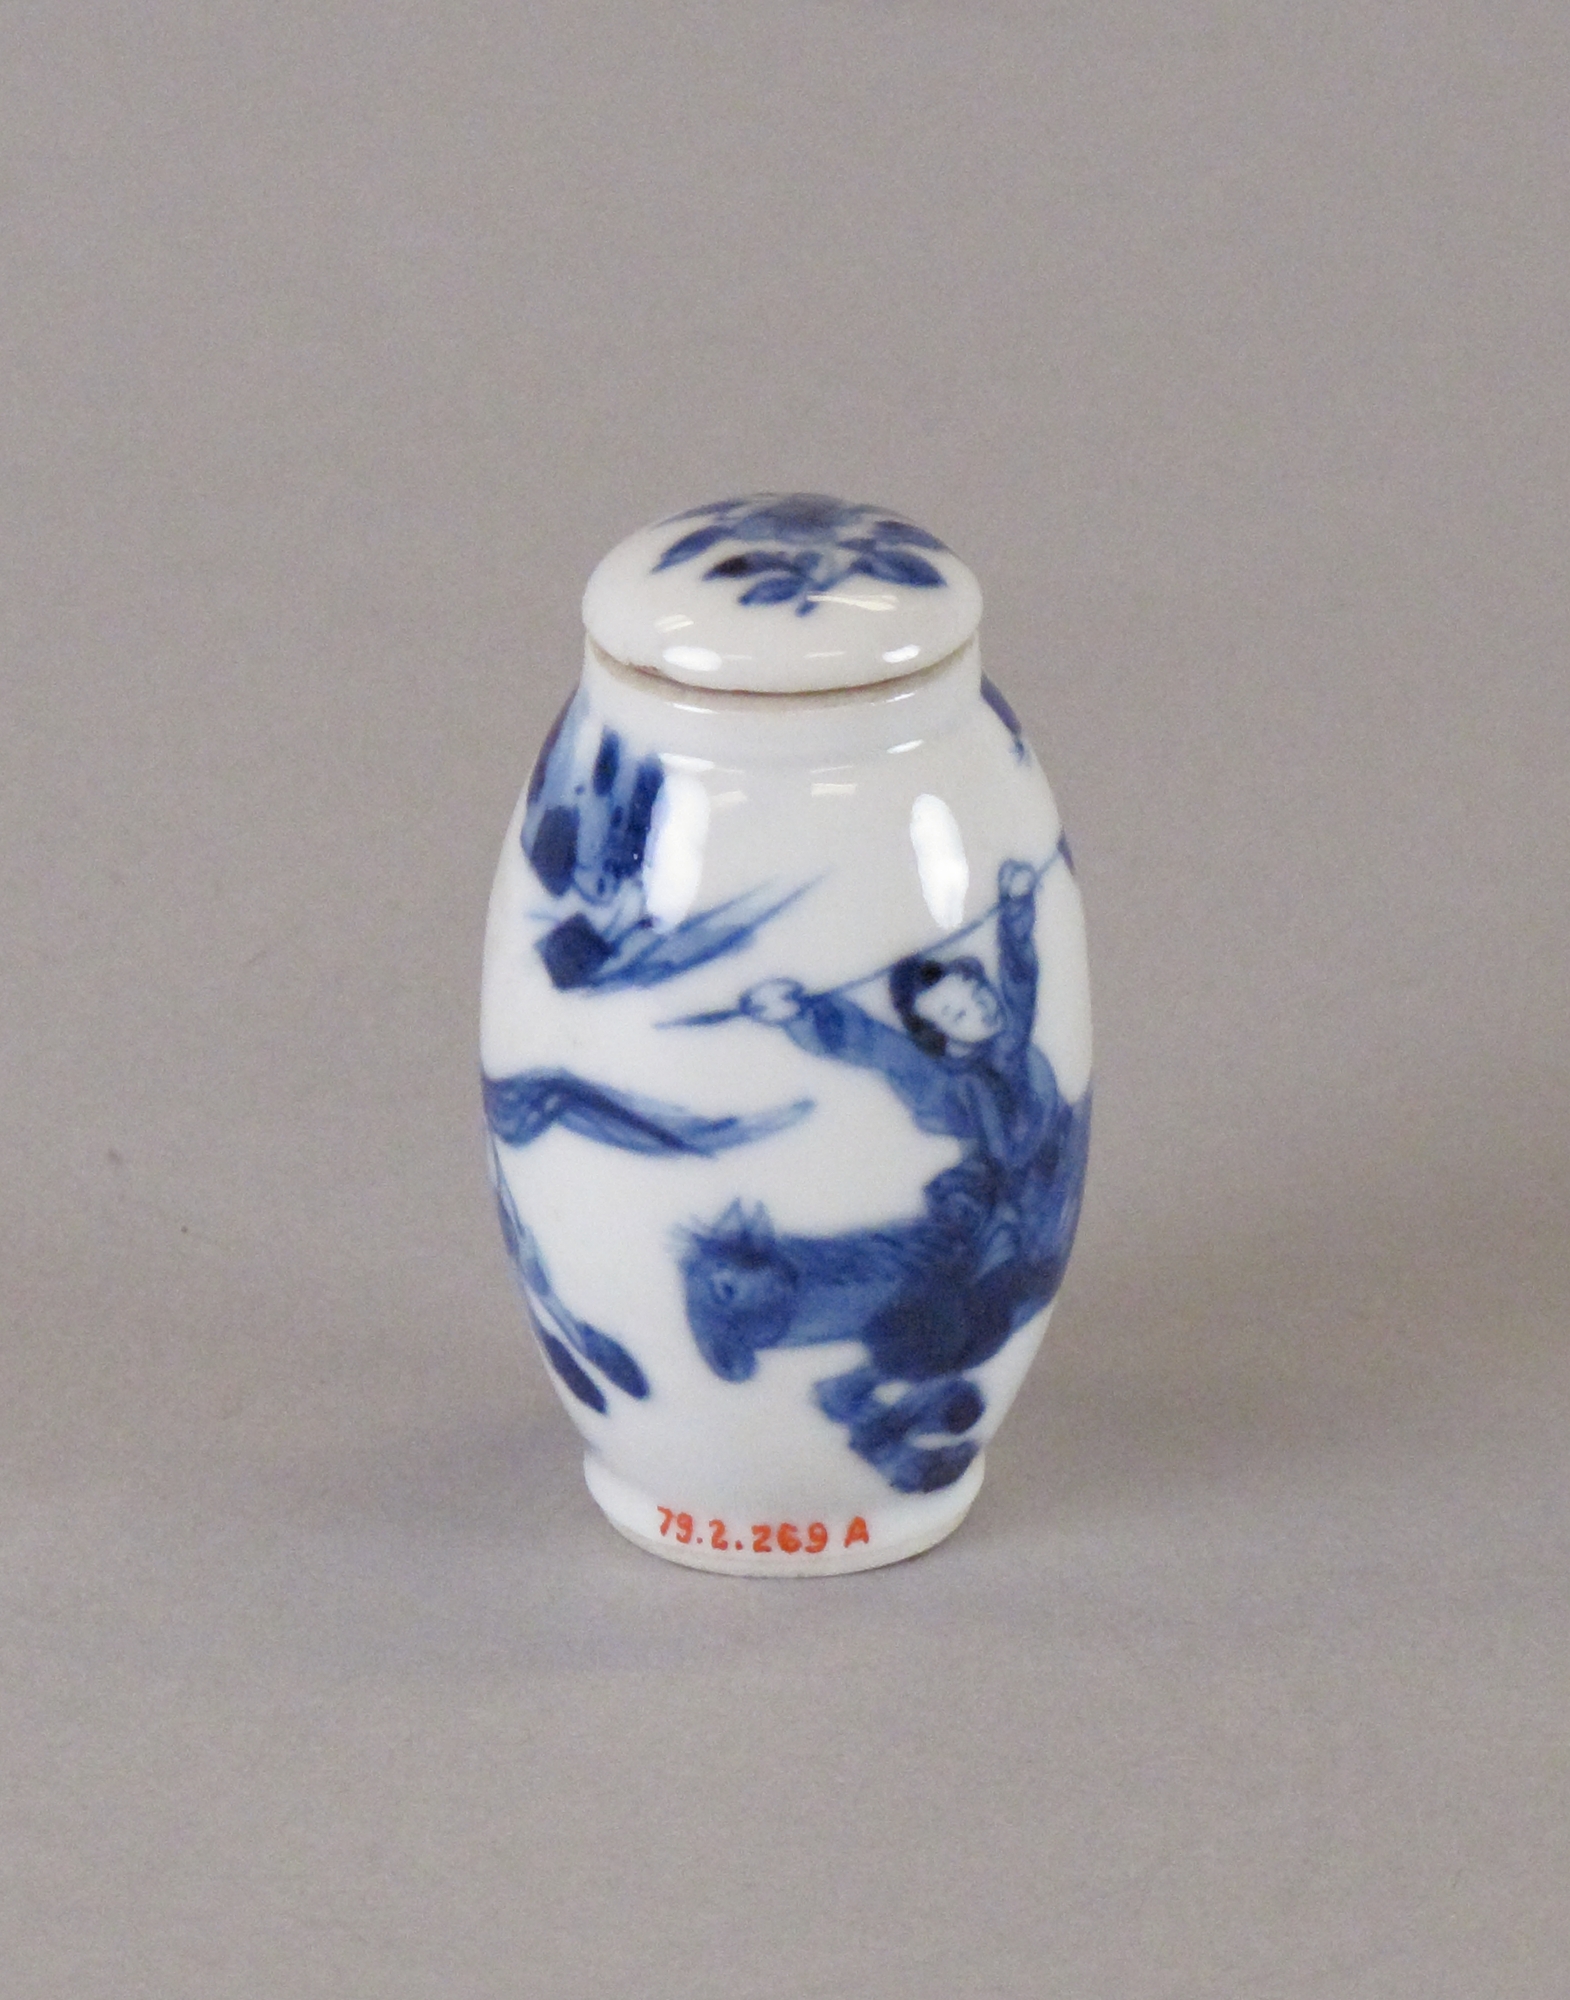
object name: covered jar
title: Jar with Female Rider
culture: chinese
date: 1634-1666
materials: cobalt, glaze, porcelain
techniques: painting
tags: women,horses